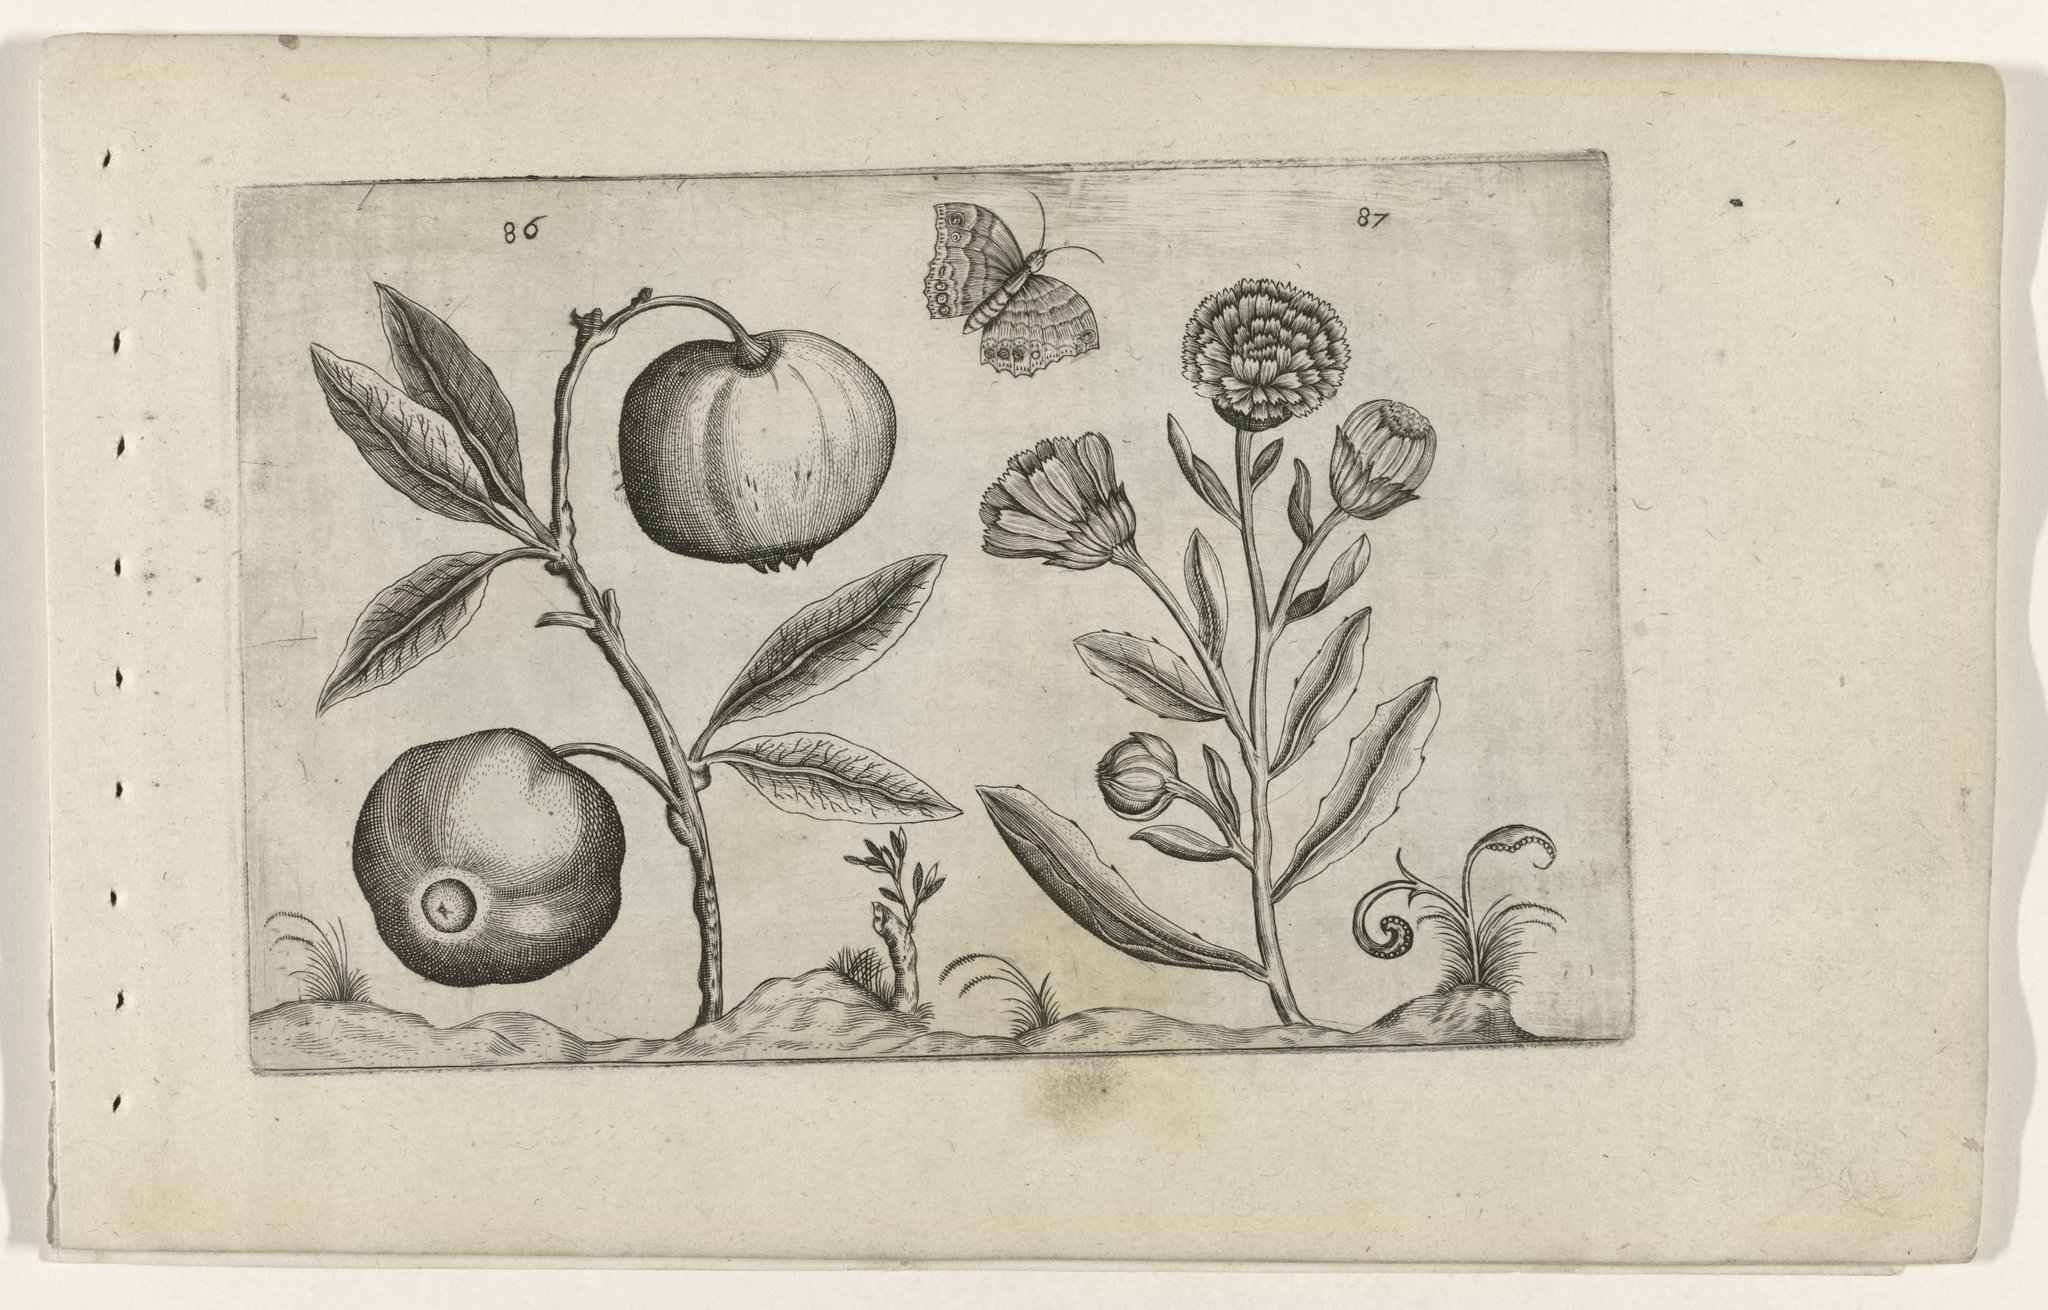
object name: album leaf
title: Cognoscite lilia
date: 1600-1604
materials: paper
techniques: engraving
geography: cologne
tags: fruits: apple, flowers: calendula, botany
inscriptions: collector's mark: Lugt 2228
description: De prenten RP-P-2012-24-1 t/m 61 waren oorspronkelijk als serie samengebonden. De naaigaten op de bladen zijn nog zichtbaar. Het betreft de reeks getiteld: Cognoscite lilia, bestaande uit een titelprent en 60 gravures met 119 genummerde weergaven van planten, bloemen en vruchten, versierd met rinceaux en kleine voorstellingen van dieren. Het gaat om proefdrukken van deze reeks gravures, voor de opschriften en, deels, voor de nummering. Op enkele prenten zijn de nummers met de hand aangebracht. Op de titelprent ontbreekt nog het adres van Crispijn de Passe en Hans Woutneel. De titel is hoogstwaarschijnlijk gegraveerd door Matthias Quad. Deze werkte voor De Passe in Keulen tot 1604. De reeks moet in dit jaar of daarvoor tot stand zijn gebracht. In ieder geval voor 1608, aangezien de uitgever Hans Woutneel in of voor dat jaar overleed. In ieder geval voor 1608, aangezien de uitgever Hans Woutneel in of voor dat jaar overleed. De gravures worden door Ilja Veldman en Anthony Griffiths beschouwd als eigenhandig werk van Crispijn de Passe I. Een van de prenten uit de reeks ontbreekt (nr 21-22) en is vervangen door een ingekleurde afdruk uit een latere uitgave (RP-P-2012-24-61), die onder de titel Altera Pars is opgenomen in de Hortus Floridus, uitgegeven door Crispijn de Passe I en die verder bestaat uit platen van Crispijn de Passe II. De prenten afkomstig uit deze uitgave zijn op de verso voorzien van tekst in boekdruk. De vervangende prent maakte geen deel uit van de gebonden serie aangezien dit blad als enige geen naaigaten heeft. Een deel van de planten, bloemen en vruchten in de Cognoscite lilia gaat terug of is gebaseerd op een reeks aquarellen van Jacques LeMoyne uit circa 1580 en uit 1585, nu in het Victoria and Albert Museum en de British Museum (zie P. Hulton, Jacques LeMoyne, Londen 1977, dl 1, p. 156-162 en p. 165-173).